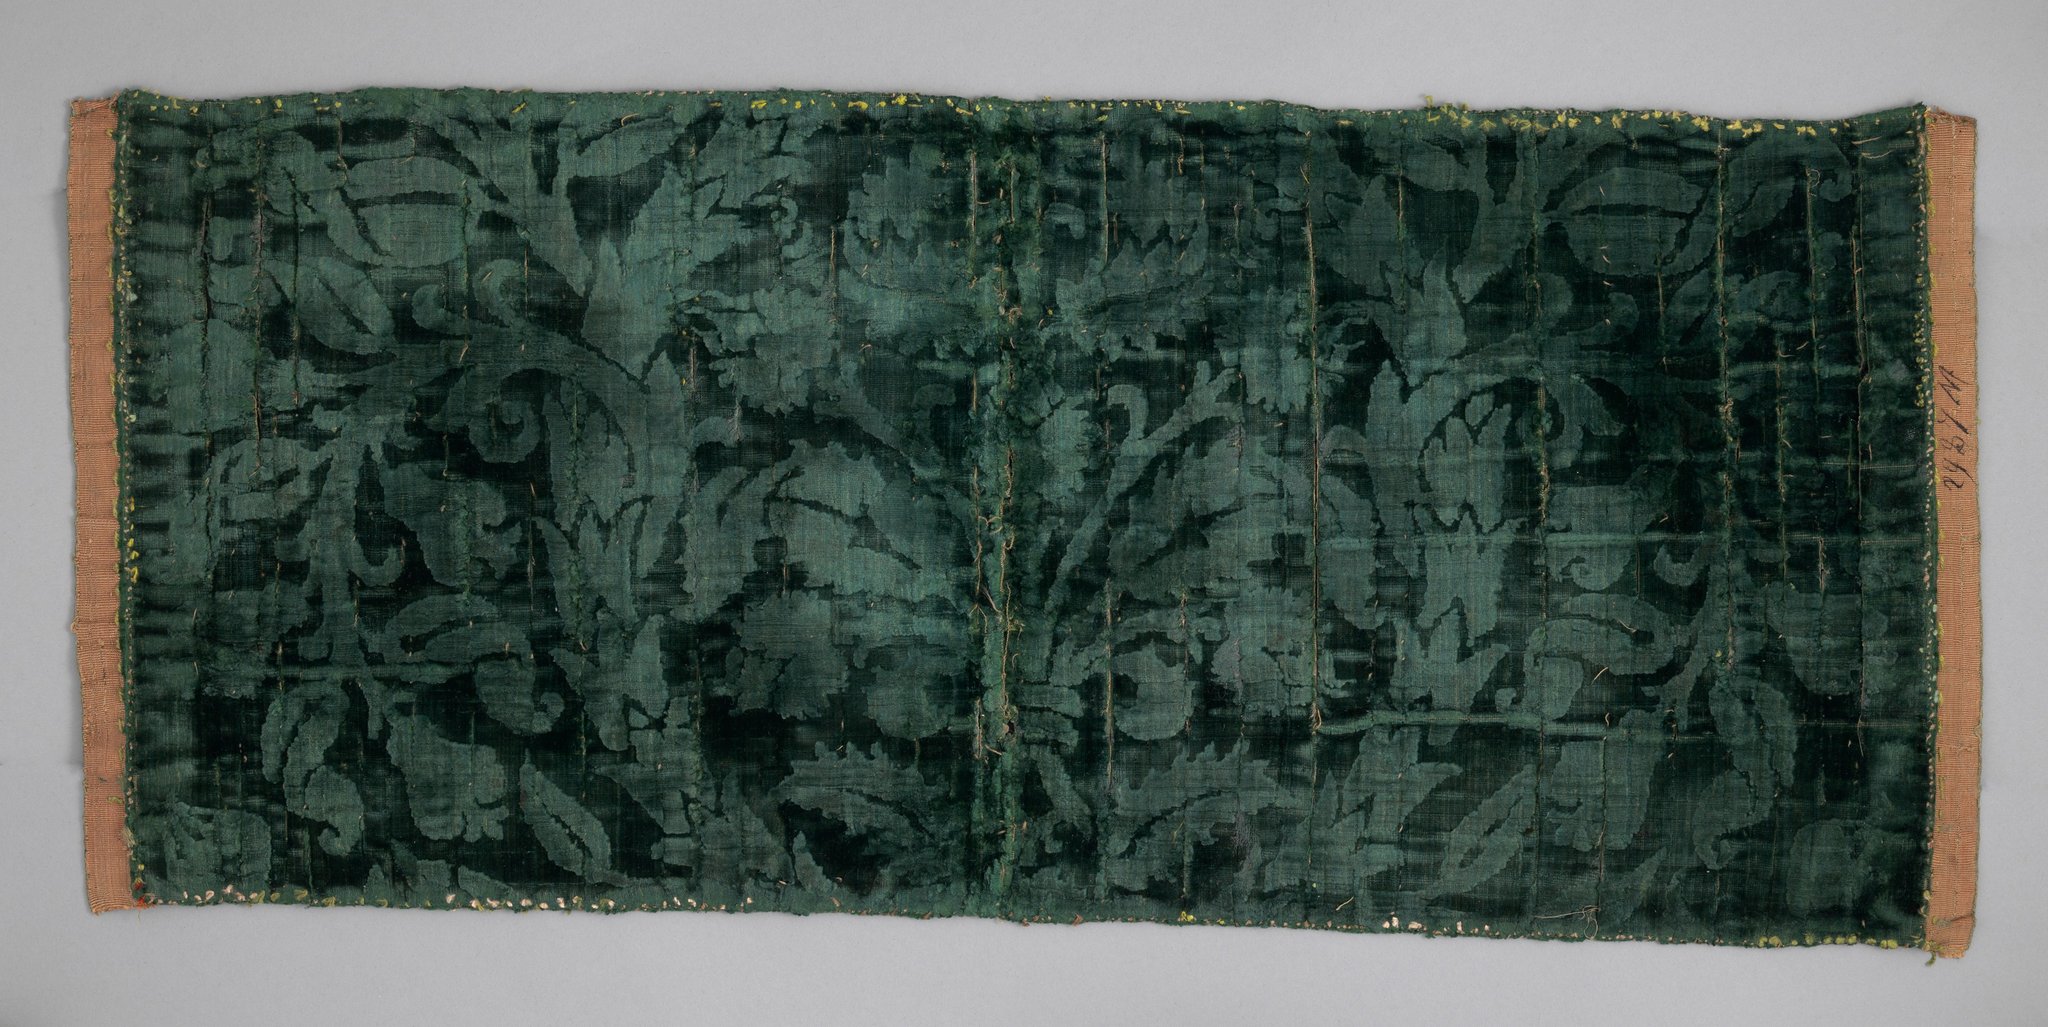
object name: fragment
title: Fragment with Sempervivum tectorum motif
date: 1475-1525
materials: silk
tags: leaves